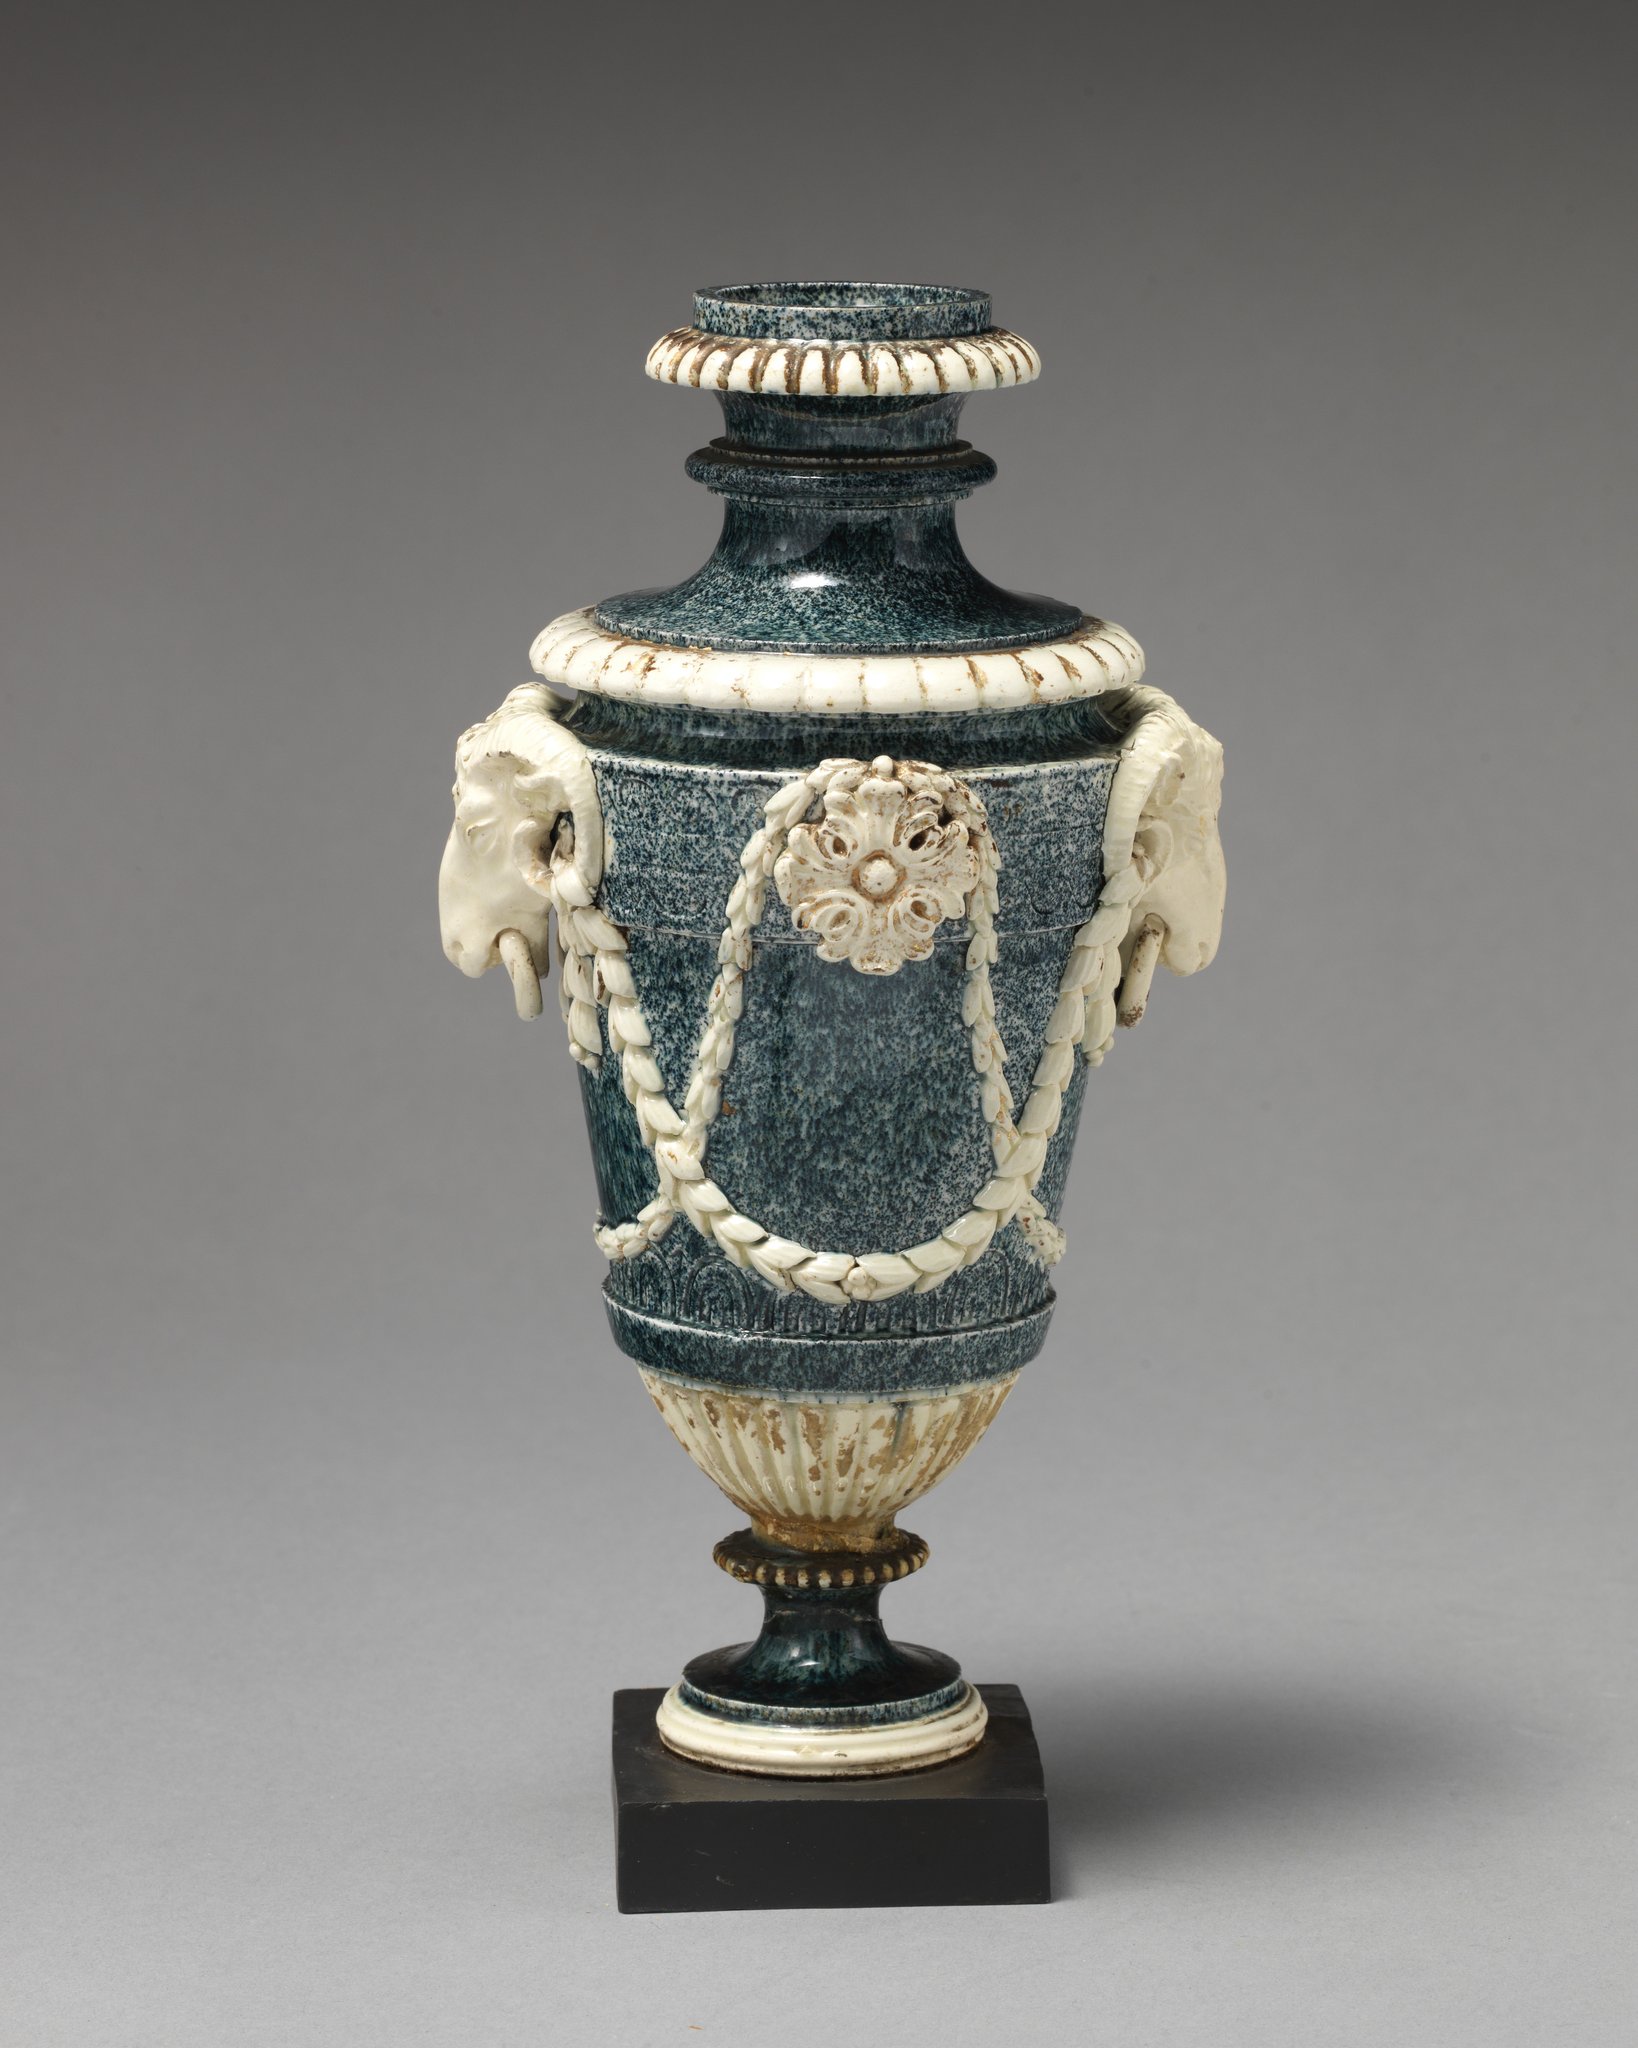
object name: vase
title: Vase (one of a pair)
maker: humphrey palmer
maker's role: maker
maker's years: 1760-1778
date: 1767-1800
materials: pottery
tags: animals